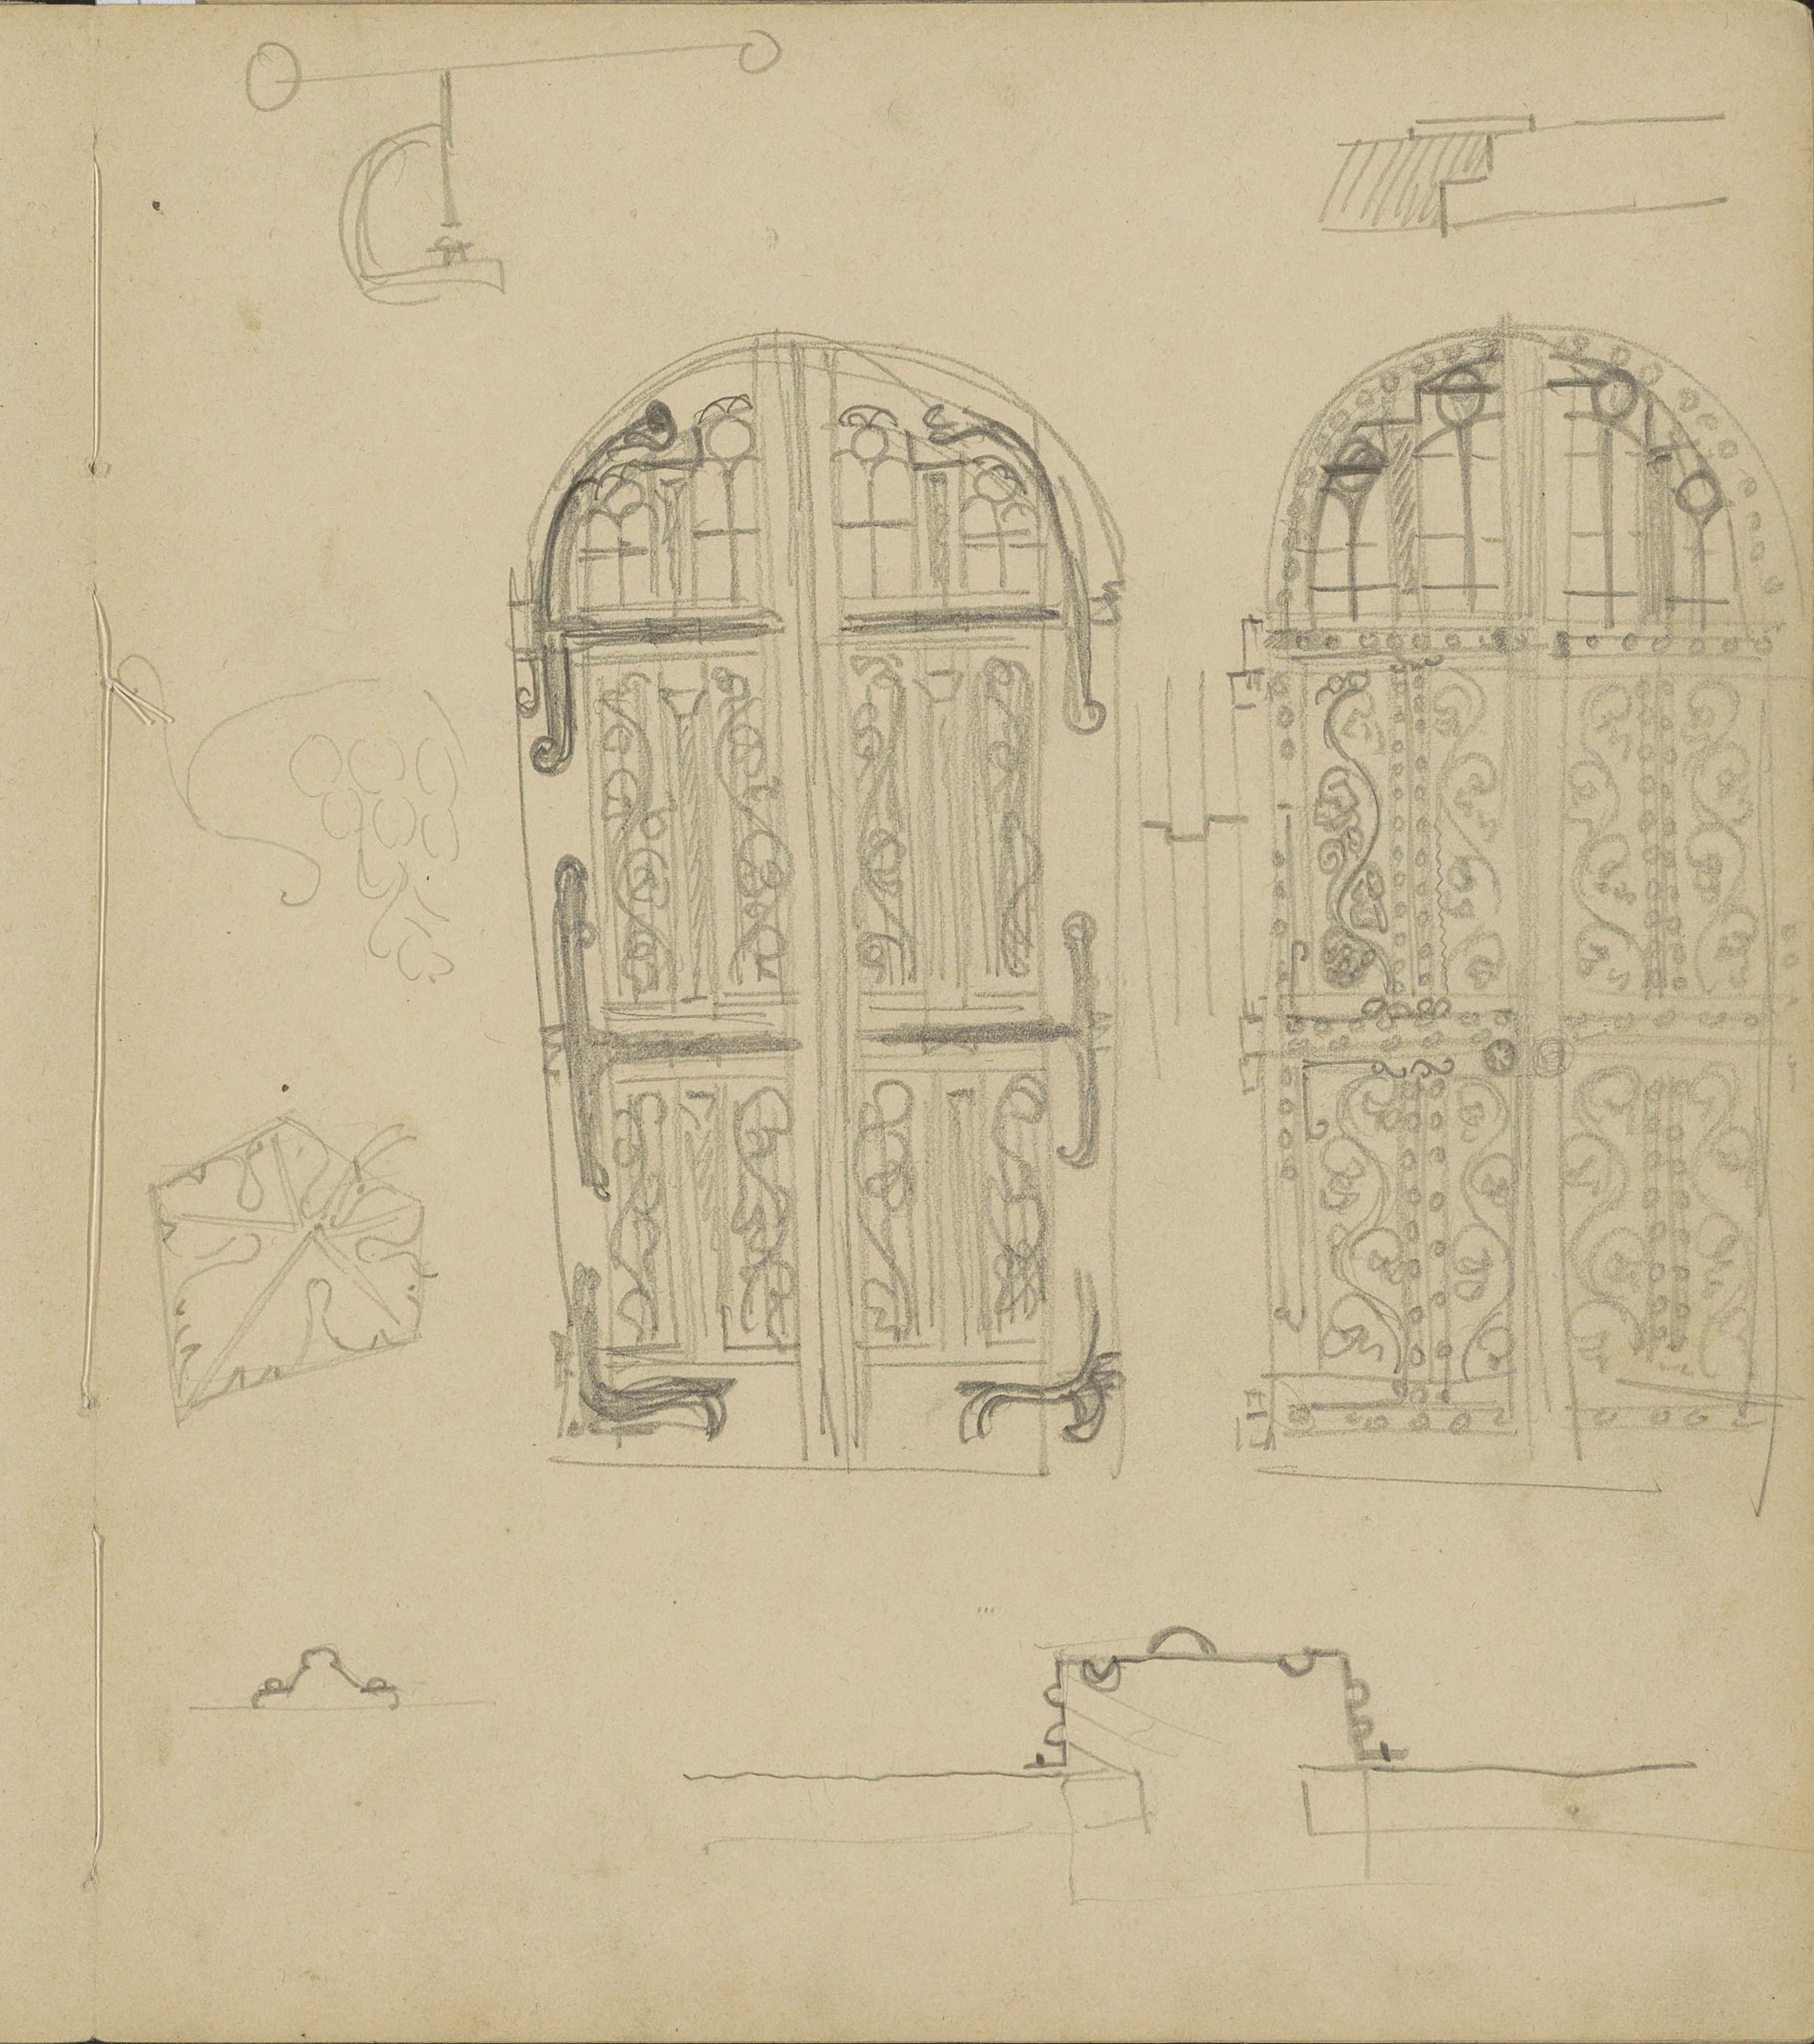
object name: sketchbook leaf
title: Kerkramen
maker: carel adolph lion cachet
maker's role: draughtsman, print maker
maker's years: 1864-1945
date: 1905-1906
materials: paper, pencil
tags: church-window, e.g. rose-window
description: Blad 9 recto uit een schetsboek met 30 bladen.